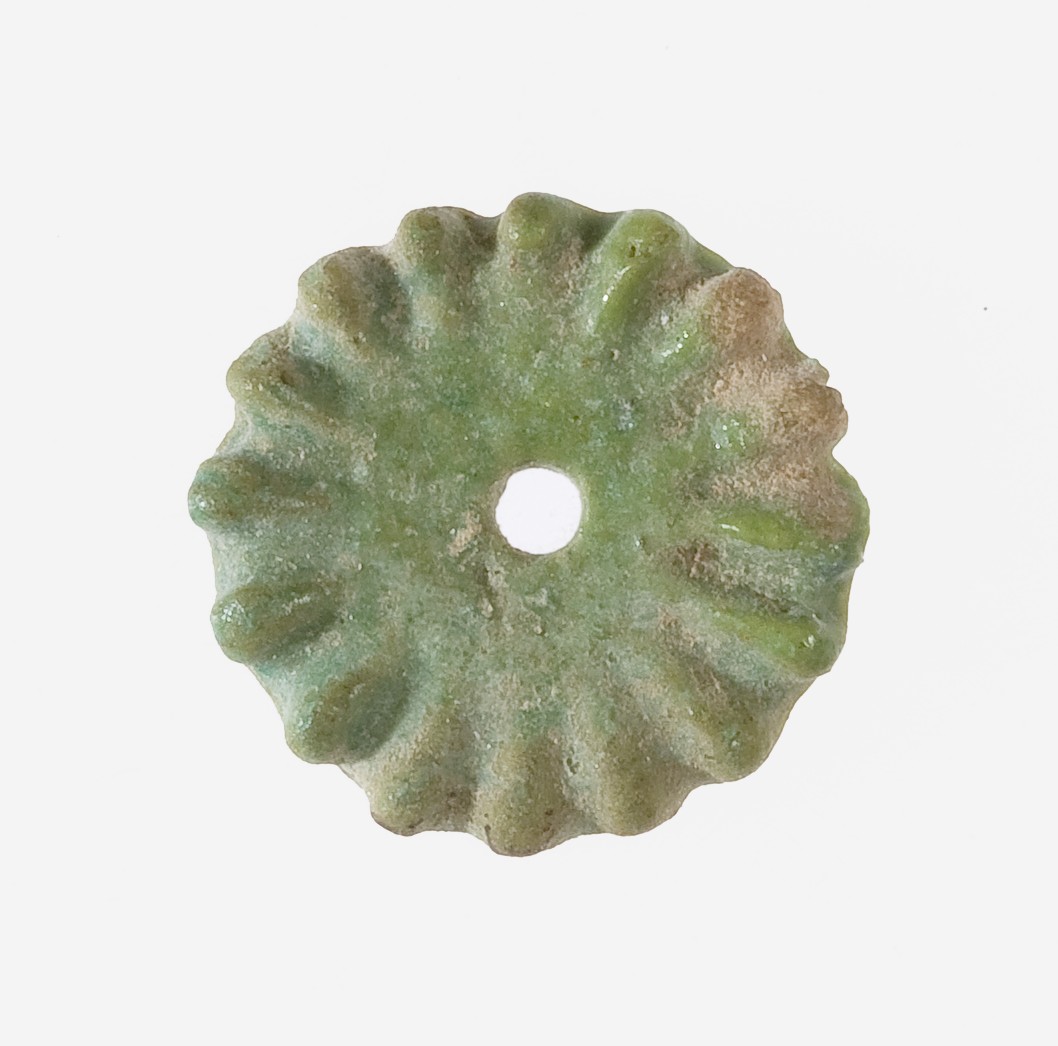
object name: pendant, rosette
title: Rosette Pendant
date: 1390-1352 BCE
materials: faience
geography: egypt